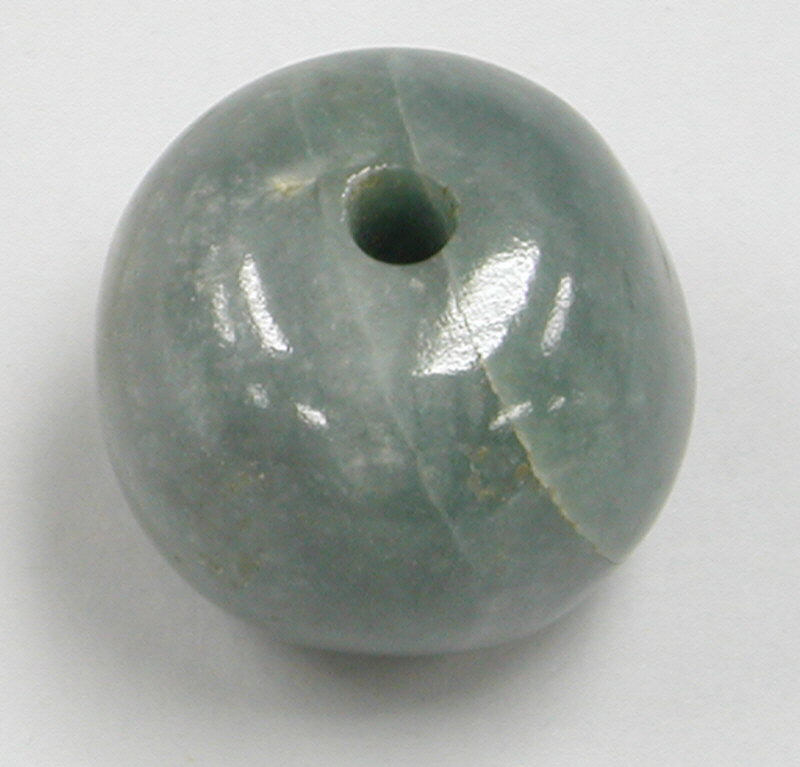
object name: bead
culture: olmec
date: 1000-301 BCE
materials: stone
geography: mexico